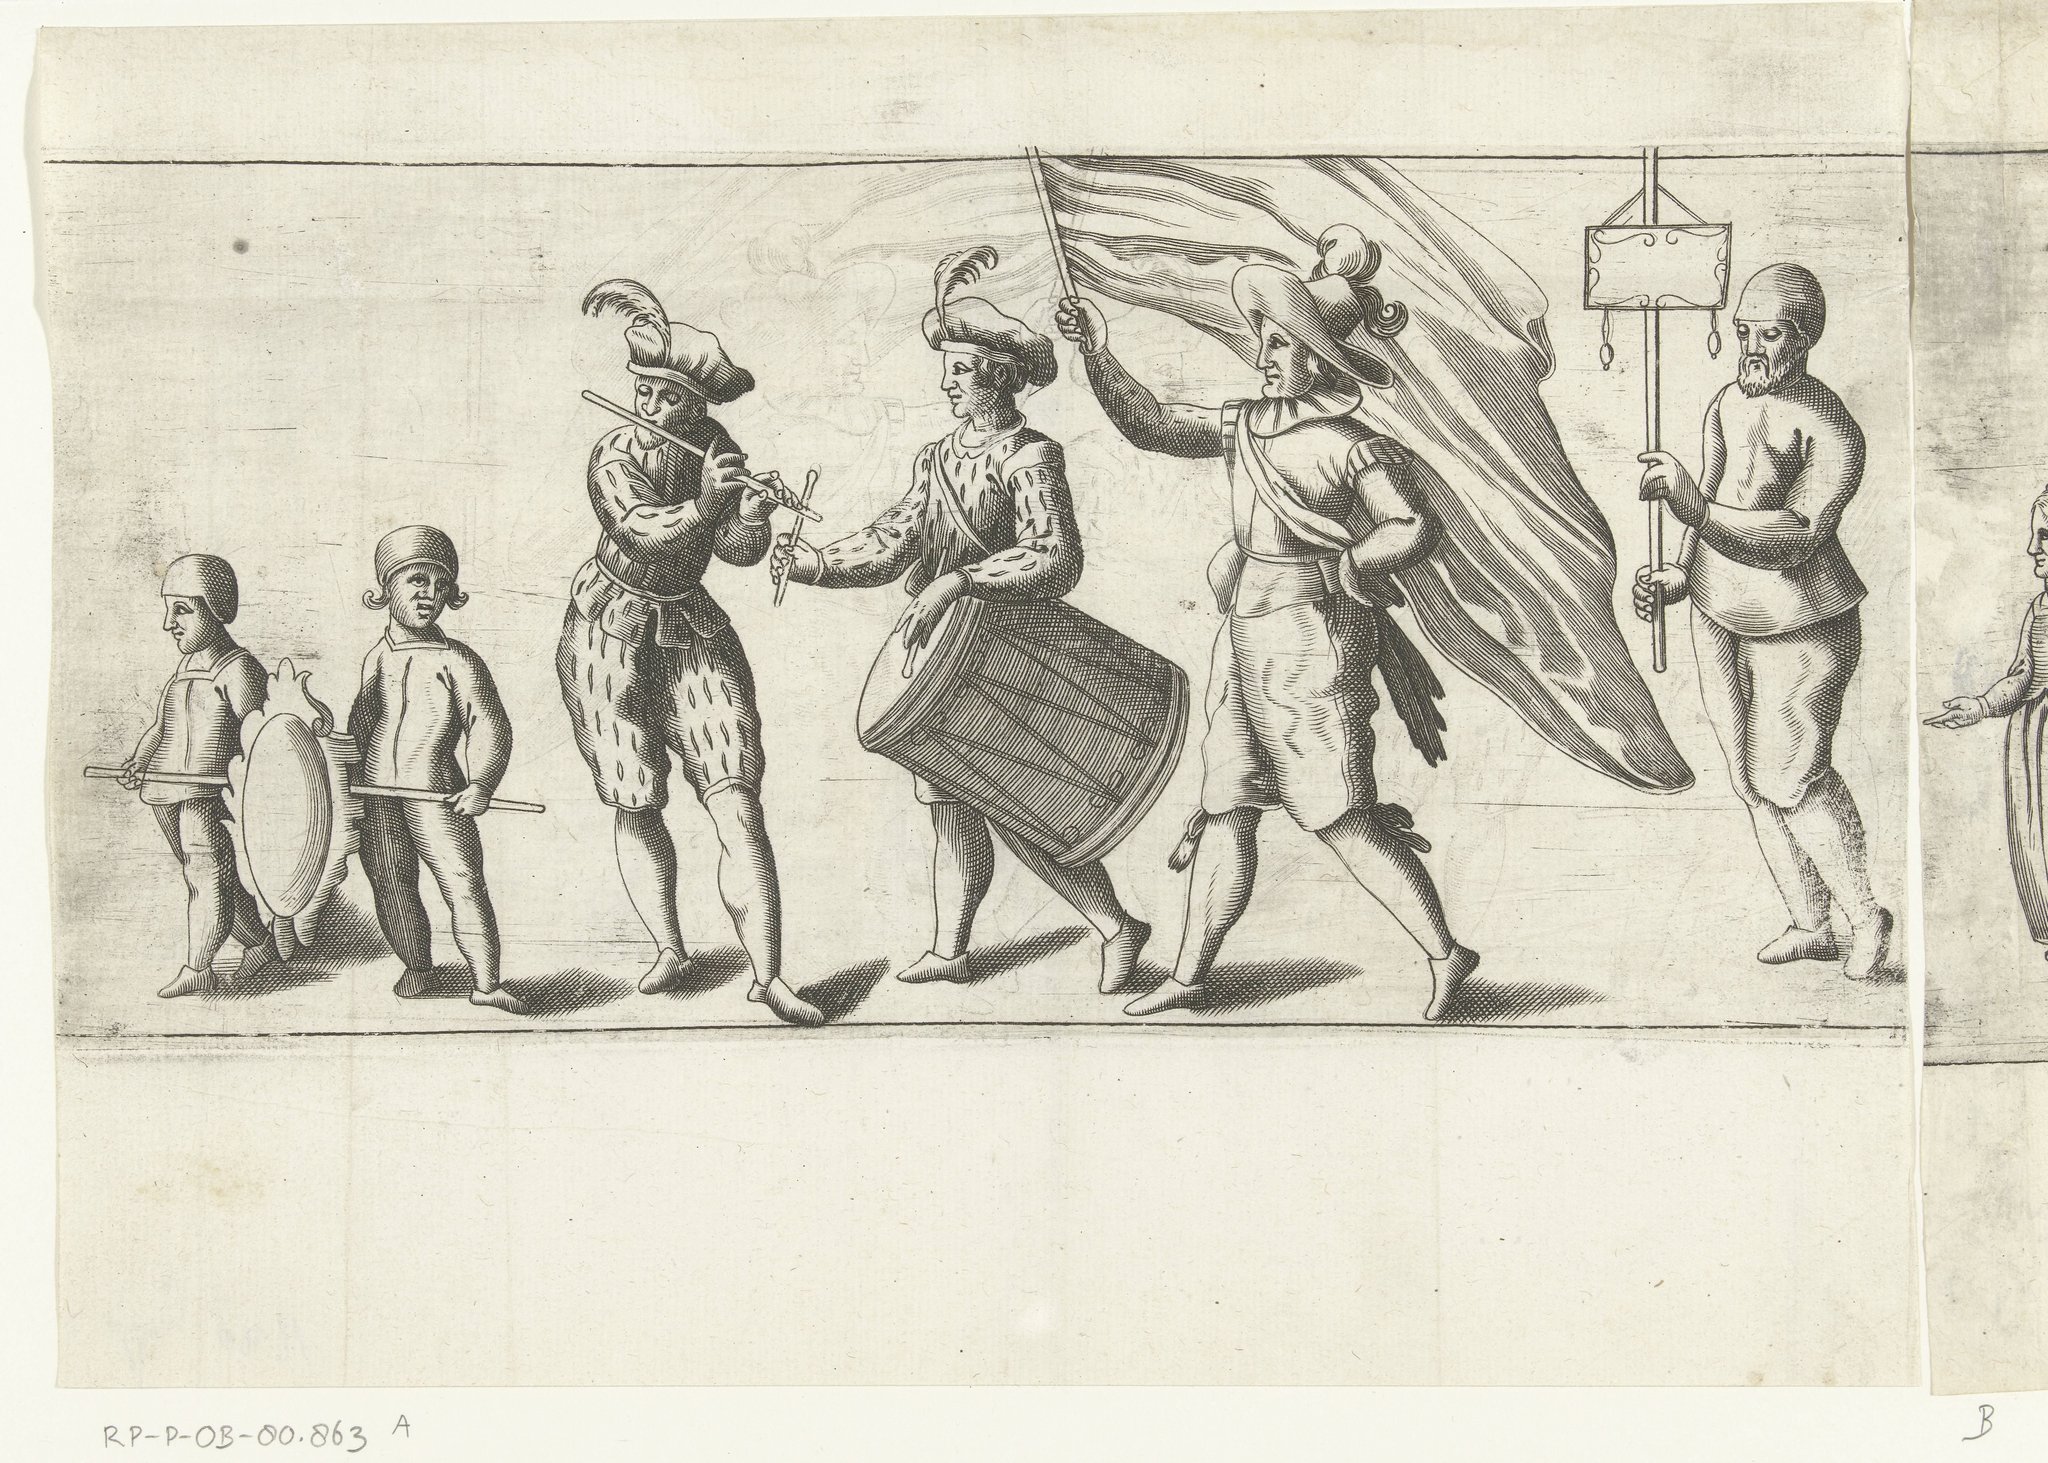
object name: print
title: De intrede van de Witte Acoleyen van Leyden verthoont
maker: Anonymous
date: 1607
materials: paper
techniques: engraving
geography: northern netherlands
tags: chamber of rhetoric (dutch: 'rederijkerskamer'), festivities (+ parade, pageant, cavalcade ~ festive activities), leiden, haarlem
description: Gebruikt als illustratie in: Const-thoonende ivweel, by de loflijcke stadt Haerlem, ten versoecke van Trou moet blijcken, in't licht gebracht. : Waer inne duydelick verclaert ende verthoont wordt alles wat den mensche mach wecken om den armen te troosten, ende zijnen naesten by te staen. : In twaelf spelen van sinne ... in redenrijck naar de volgende voorgegevene caerte van 't speel-korenken, Zacharias Heyns, Zwolle 1607. Los fragment, bedoeld om samen met de andere delen tot een fries gemonteerd te worden.